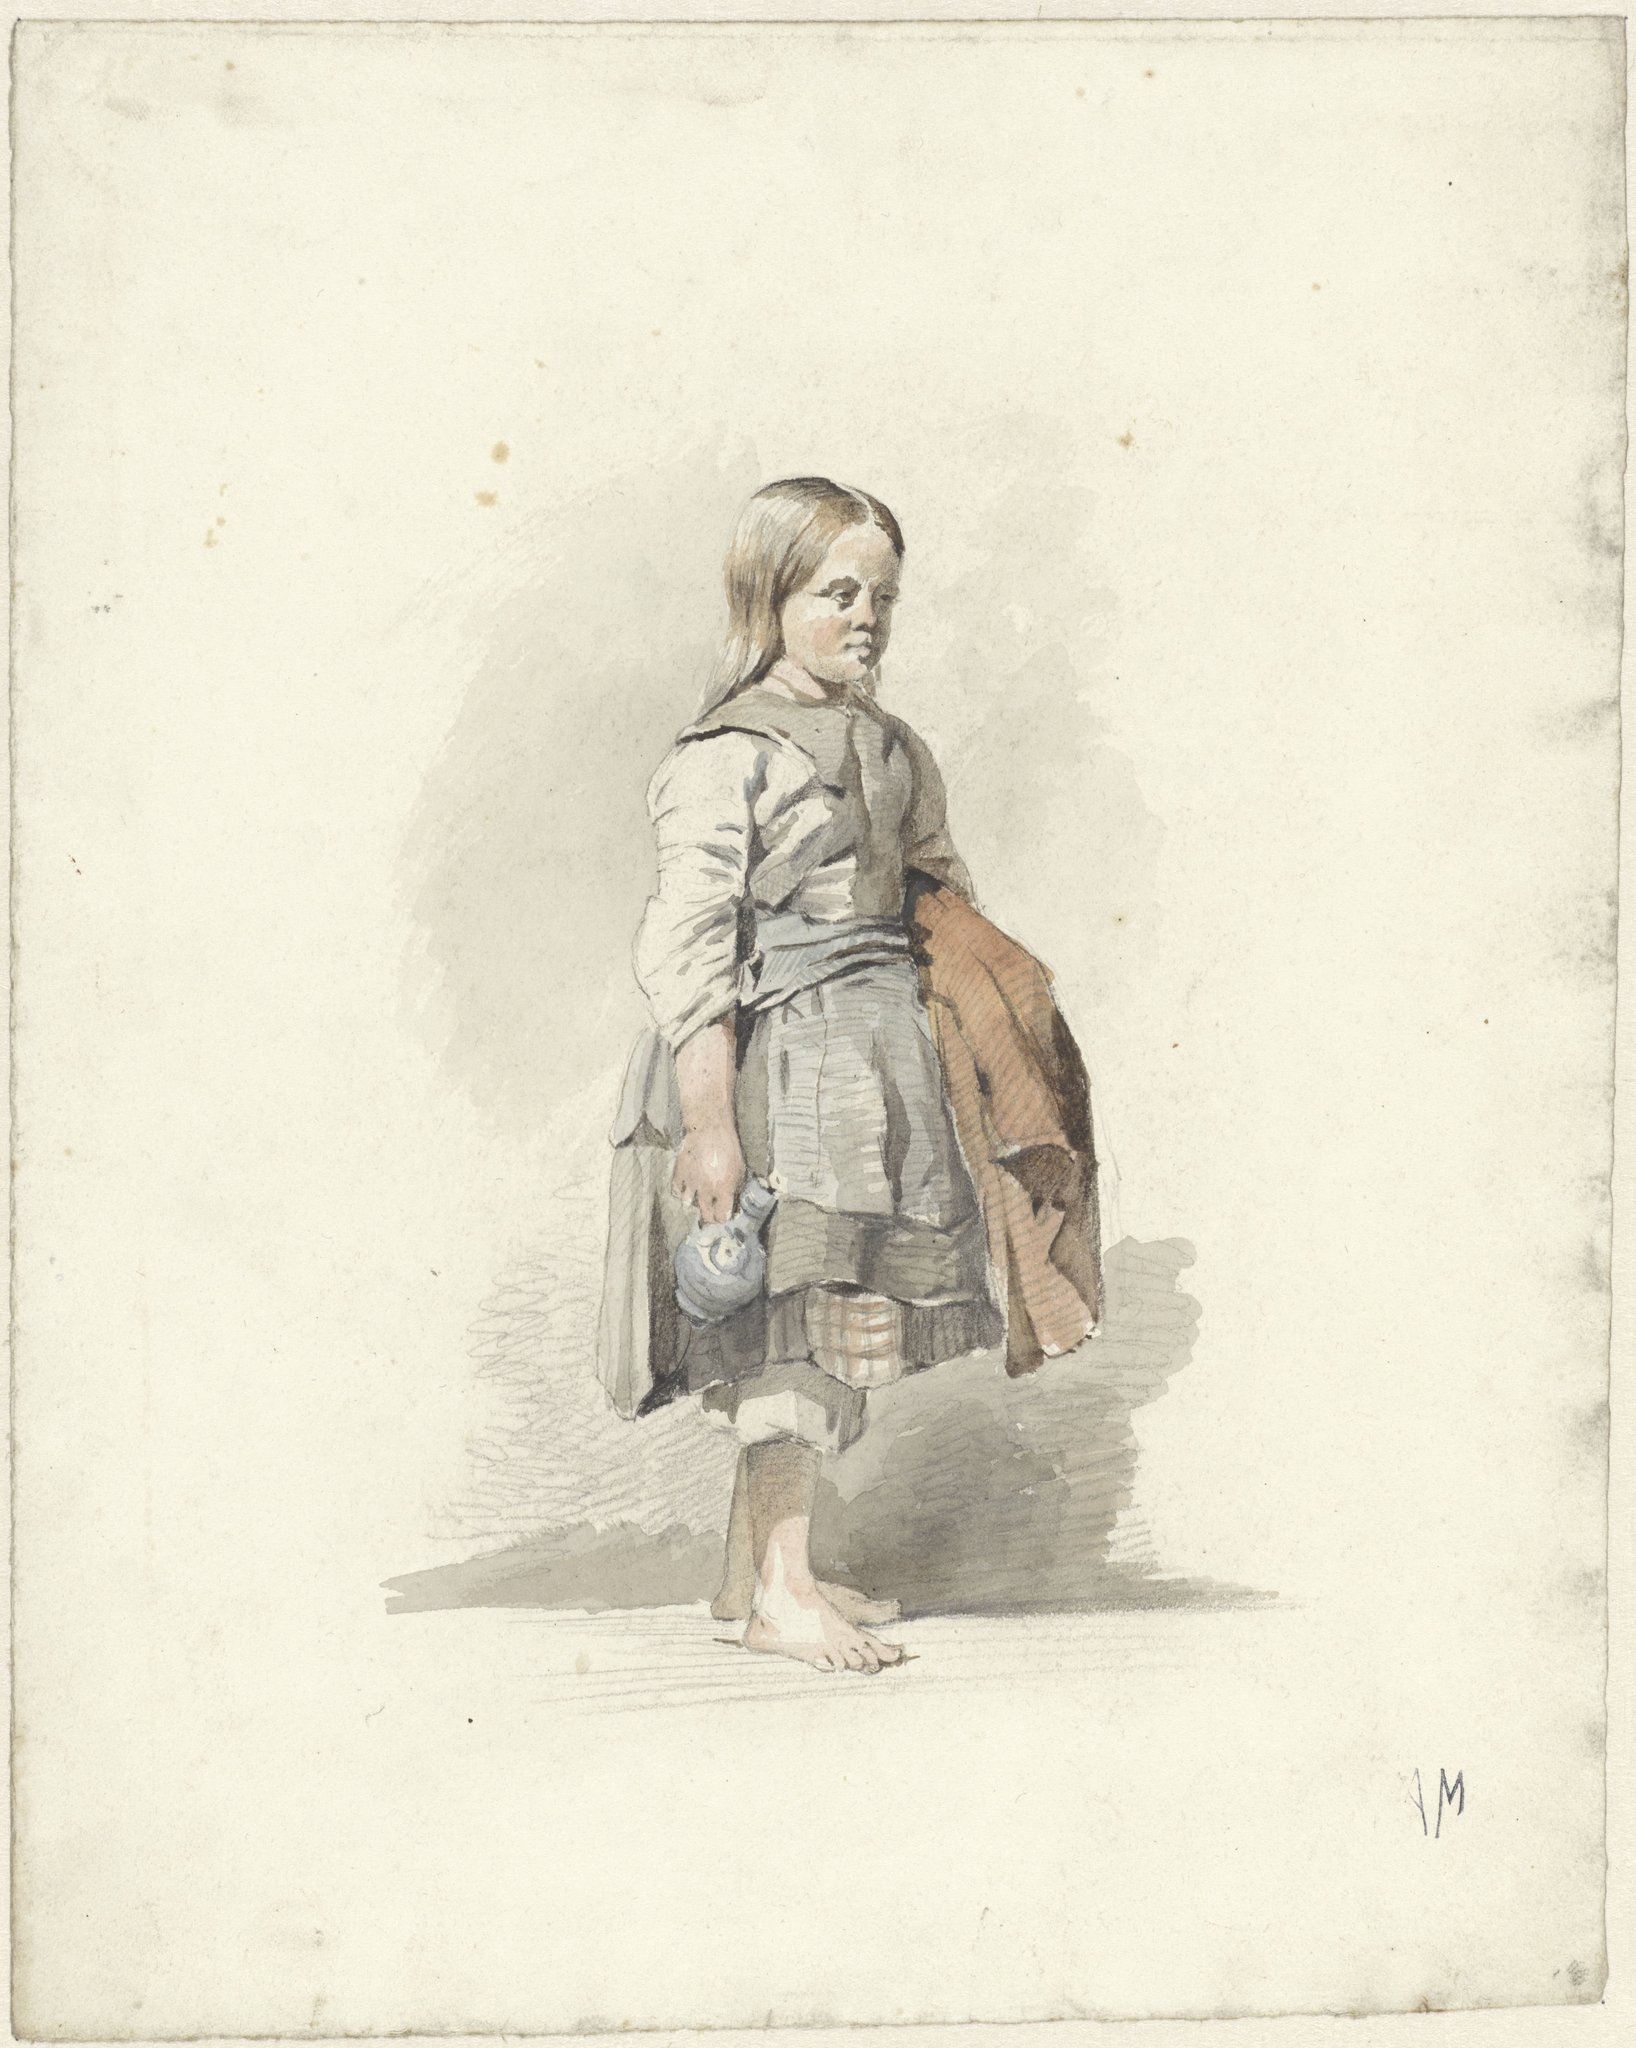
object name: drawing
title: Staand meisje met kruik en mantel onder de arm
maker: anton mauve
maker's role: draughtsman, painter, print maker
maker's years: 1838-1888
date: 1848-1888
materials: chalk, paper, pencil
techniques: brush